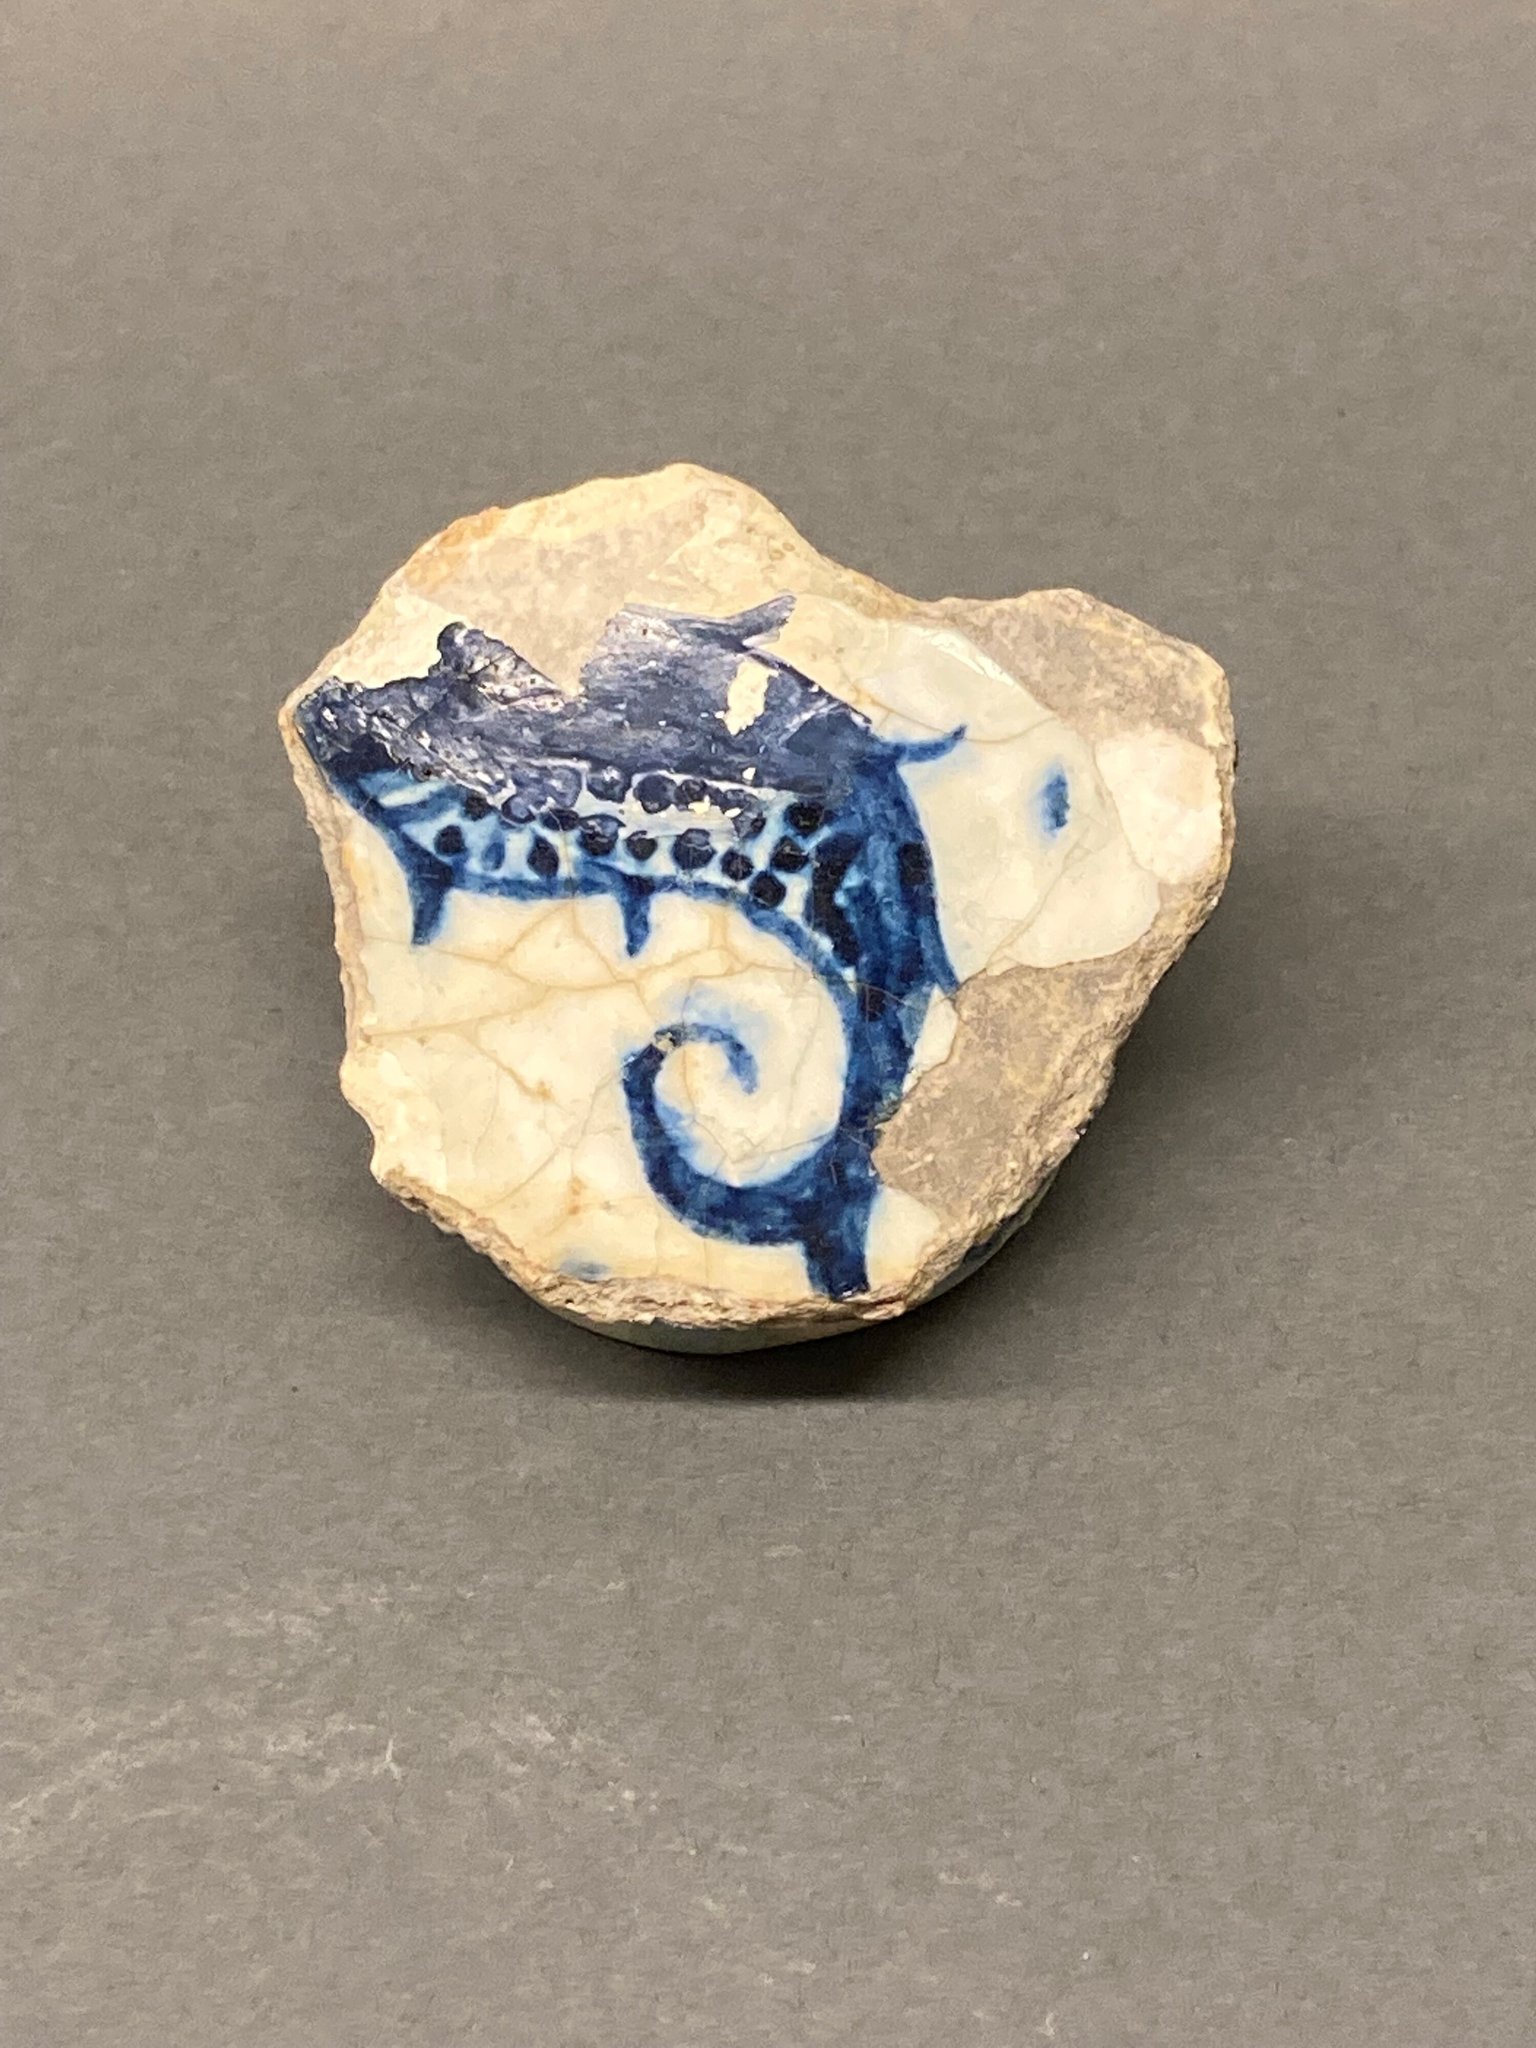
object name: fragment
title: Ceramic Fragment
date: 1201-1600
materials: glaze, stonepaste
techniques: painting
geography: egypt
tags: fish